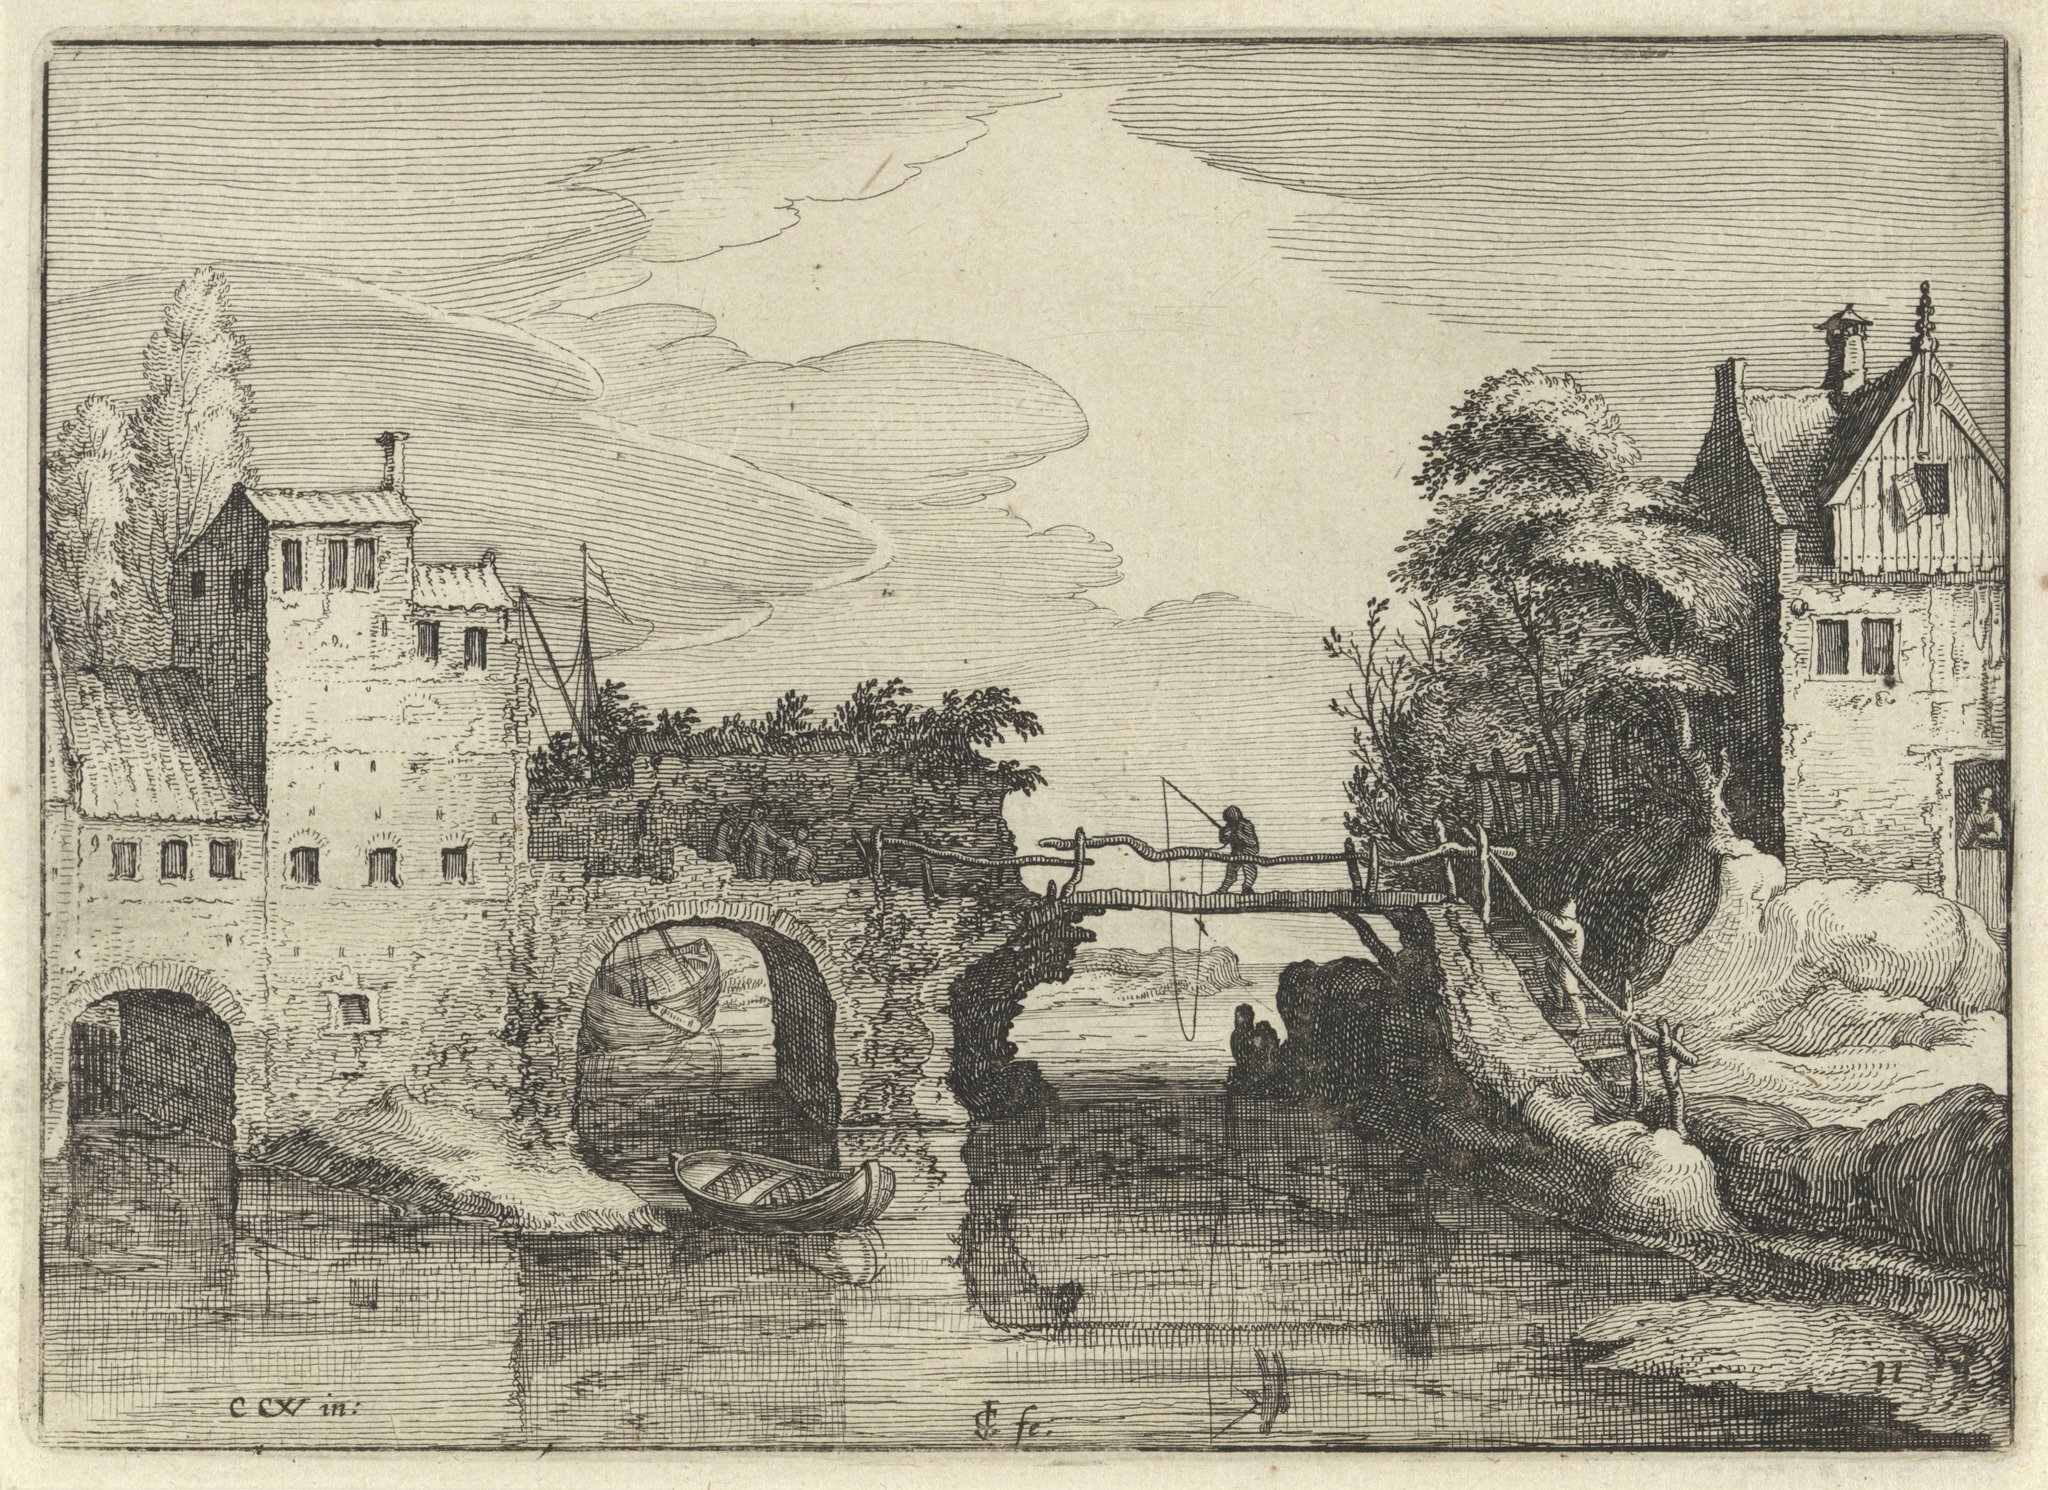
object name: print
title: Amaeniores Aliquot Regiunculae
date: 1613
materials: paper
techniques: etching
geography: amsterdam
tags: rowing-boat, canoe, etc., fisherman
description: Gezicht op een rivier waar een houten en een stenen brug overheen voeren. Op de houten brug staat een visser. Links en rechts van de rivier staan huizen.